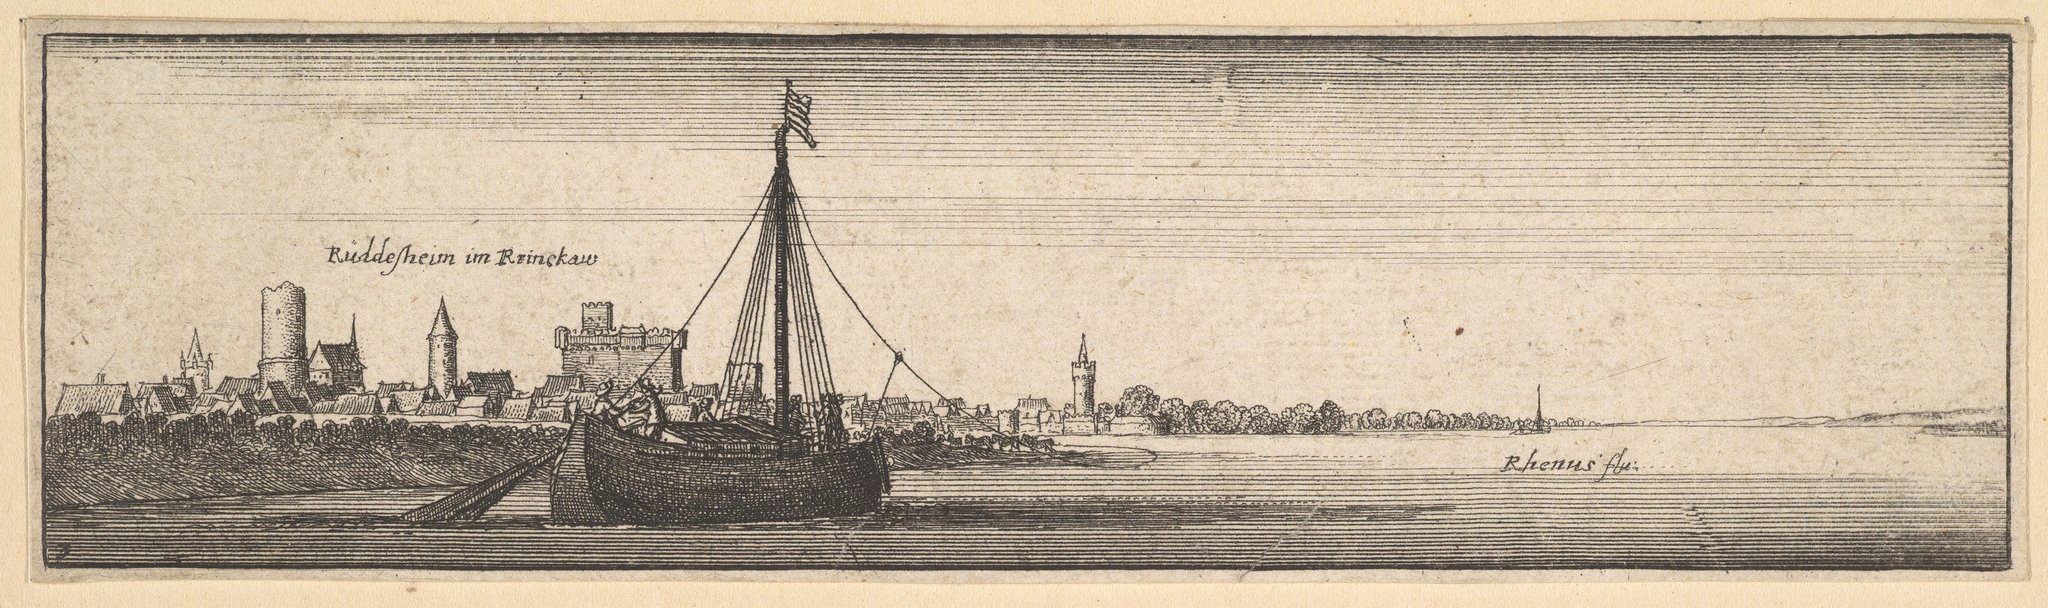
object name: print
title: Rüdesheim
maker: wenceslaus hollar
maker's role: artist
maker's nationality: bohemian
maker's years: 1607-1677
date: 1642-1644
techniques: etching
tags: rivers,ships